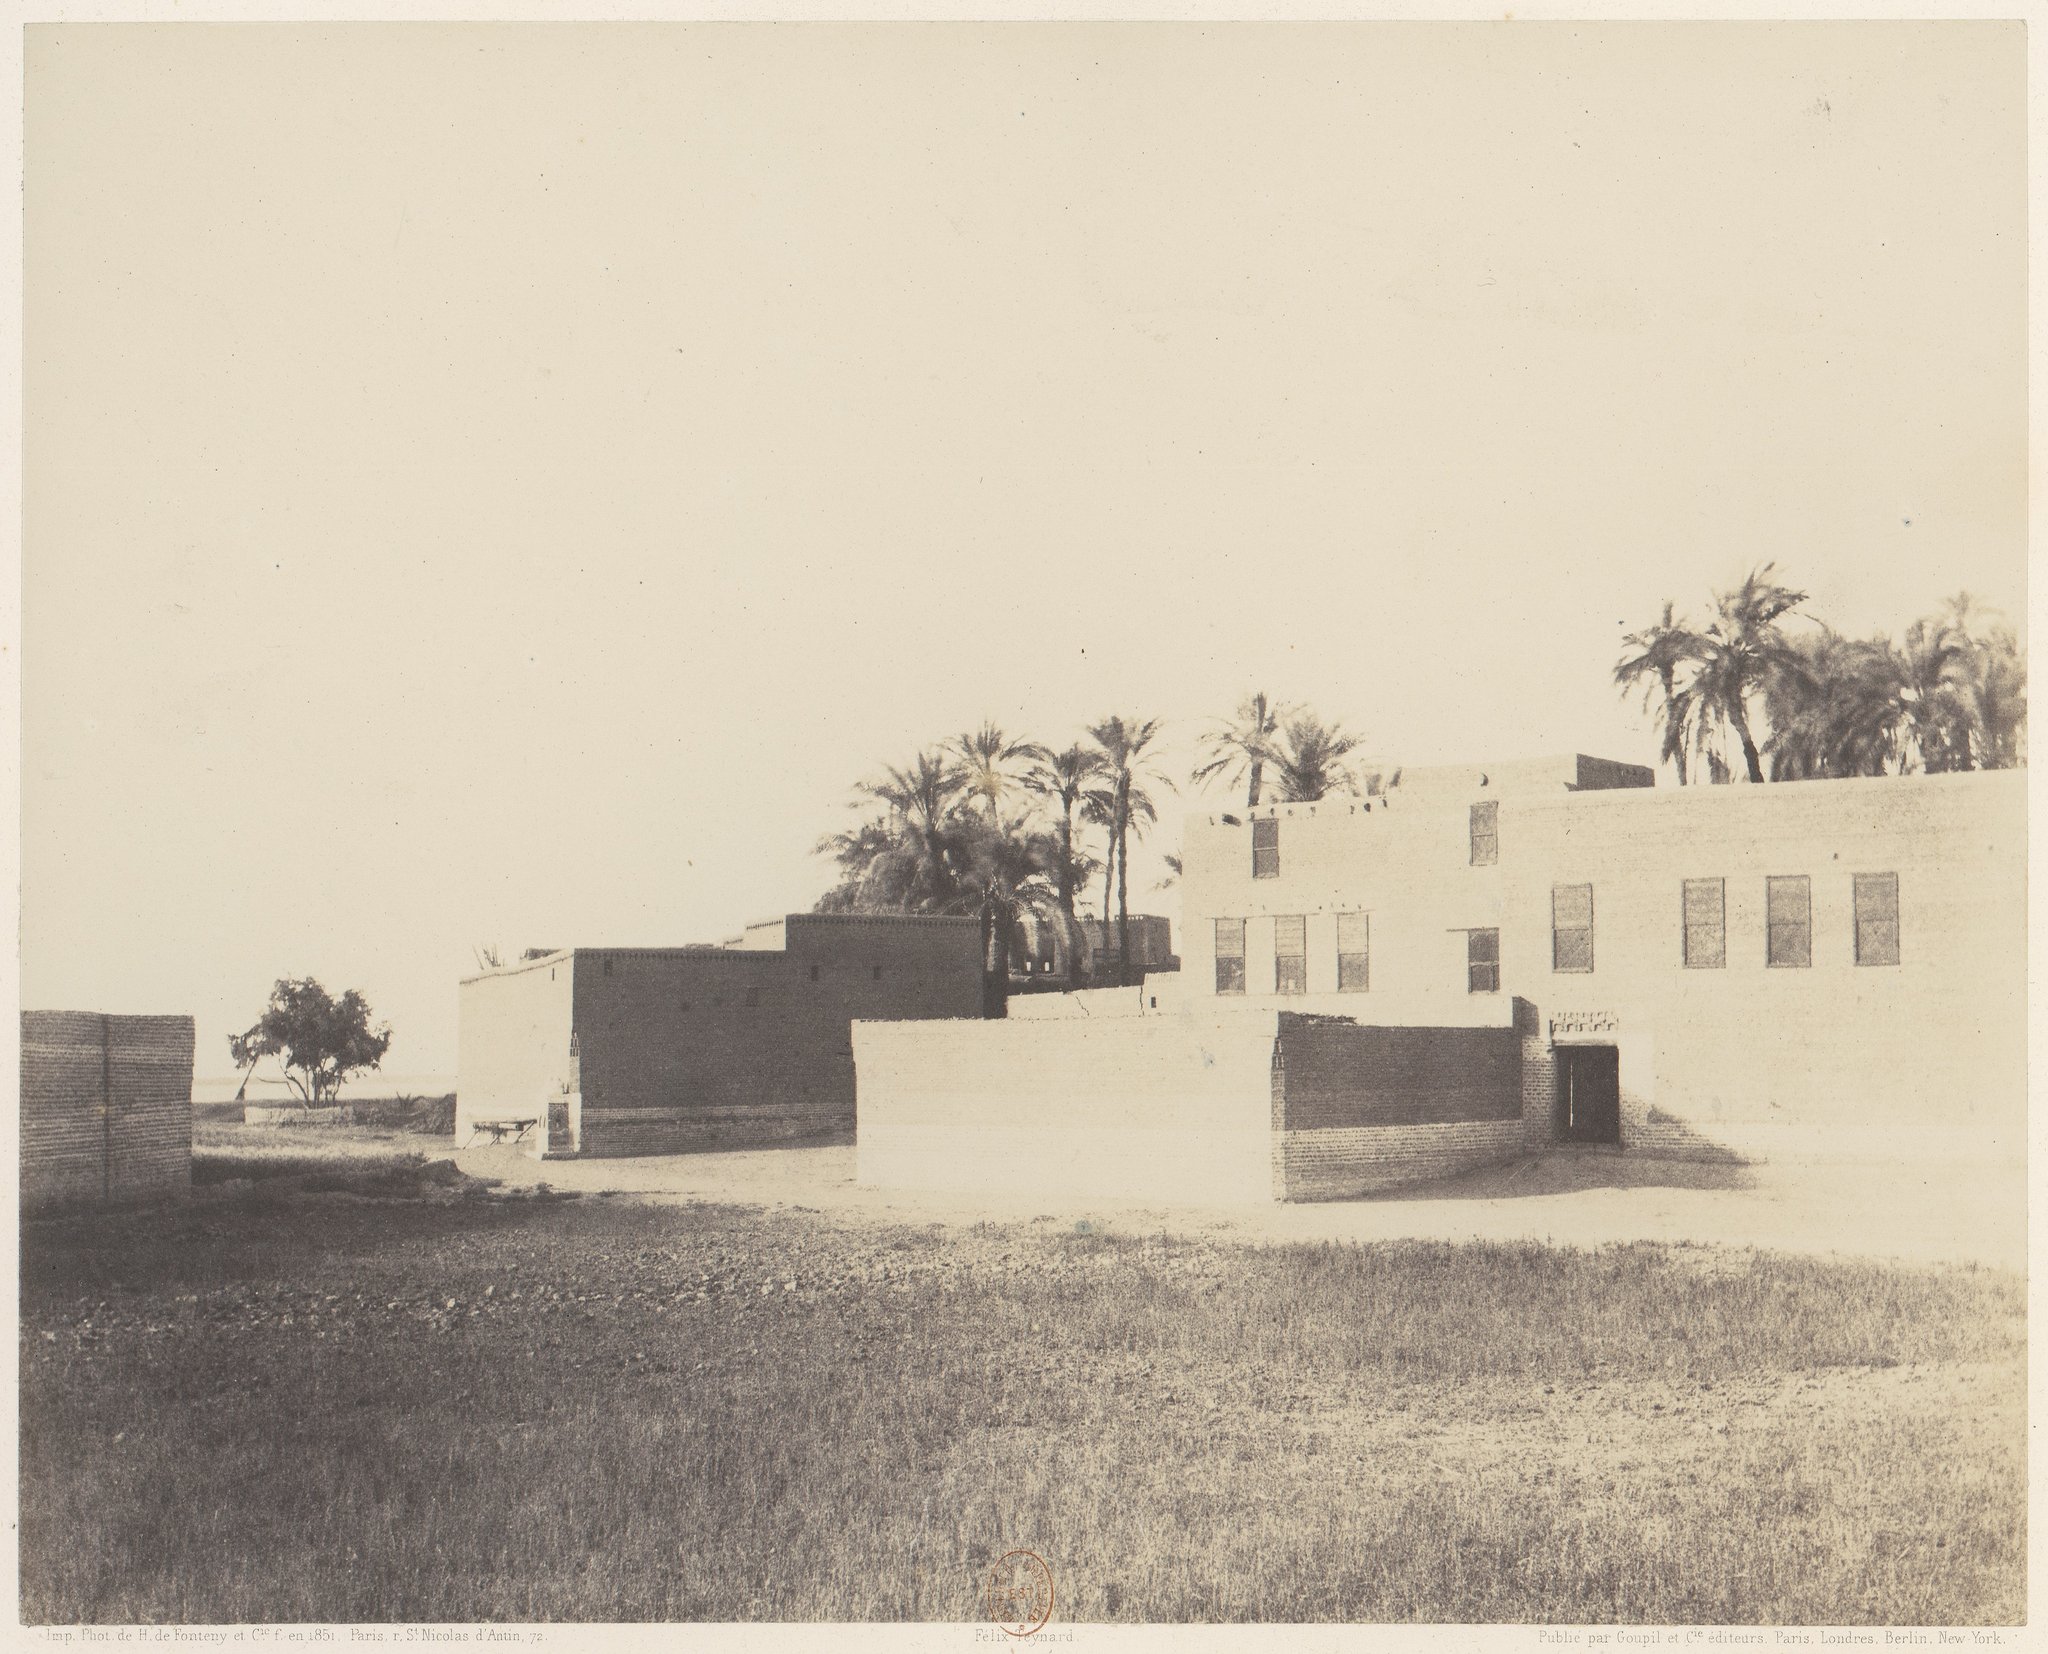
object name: photograph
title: Syout, Habitations Arabes sur le Bord du Nil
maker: félix teynard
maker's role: artist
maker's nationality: french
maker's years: 1817-1892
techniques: paper negative, salted paper print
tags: architecture,buildings